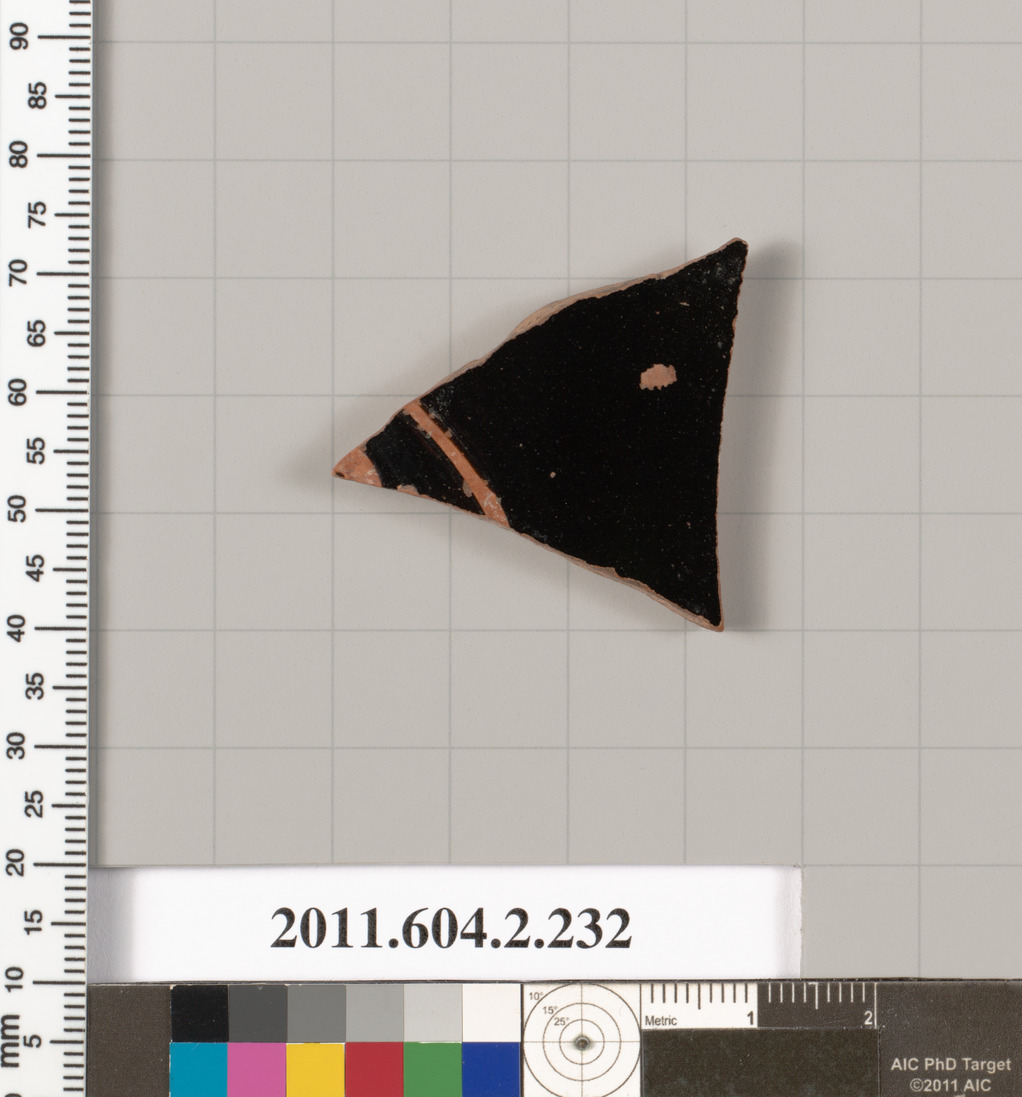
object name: stamnos fragment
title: Terracotta fragment of a stamnos (jar)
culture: greek, attic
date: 500-451 BCE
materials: terracotta